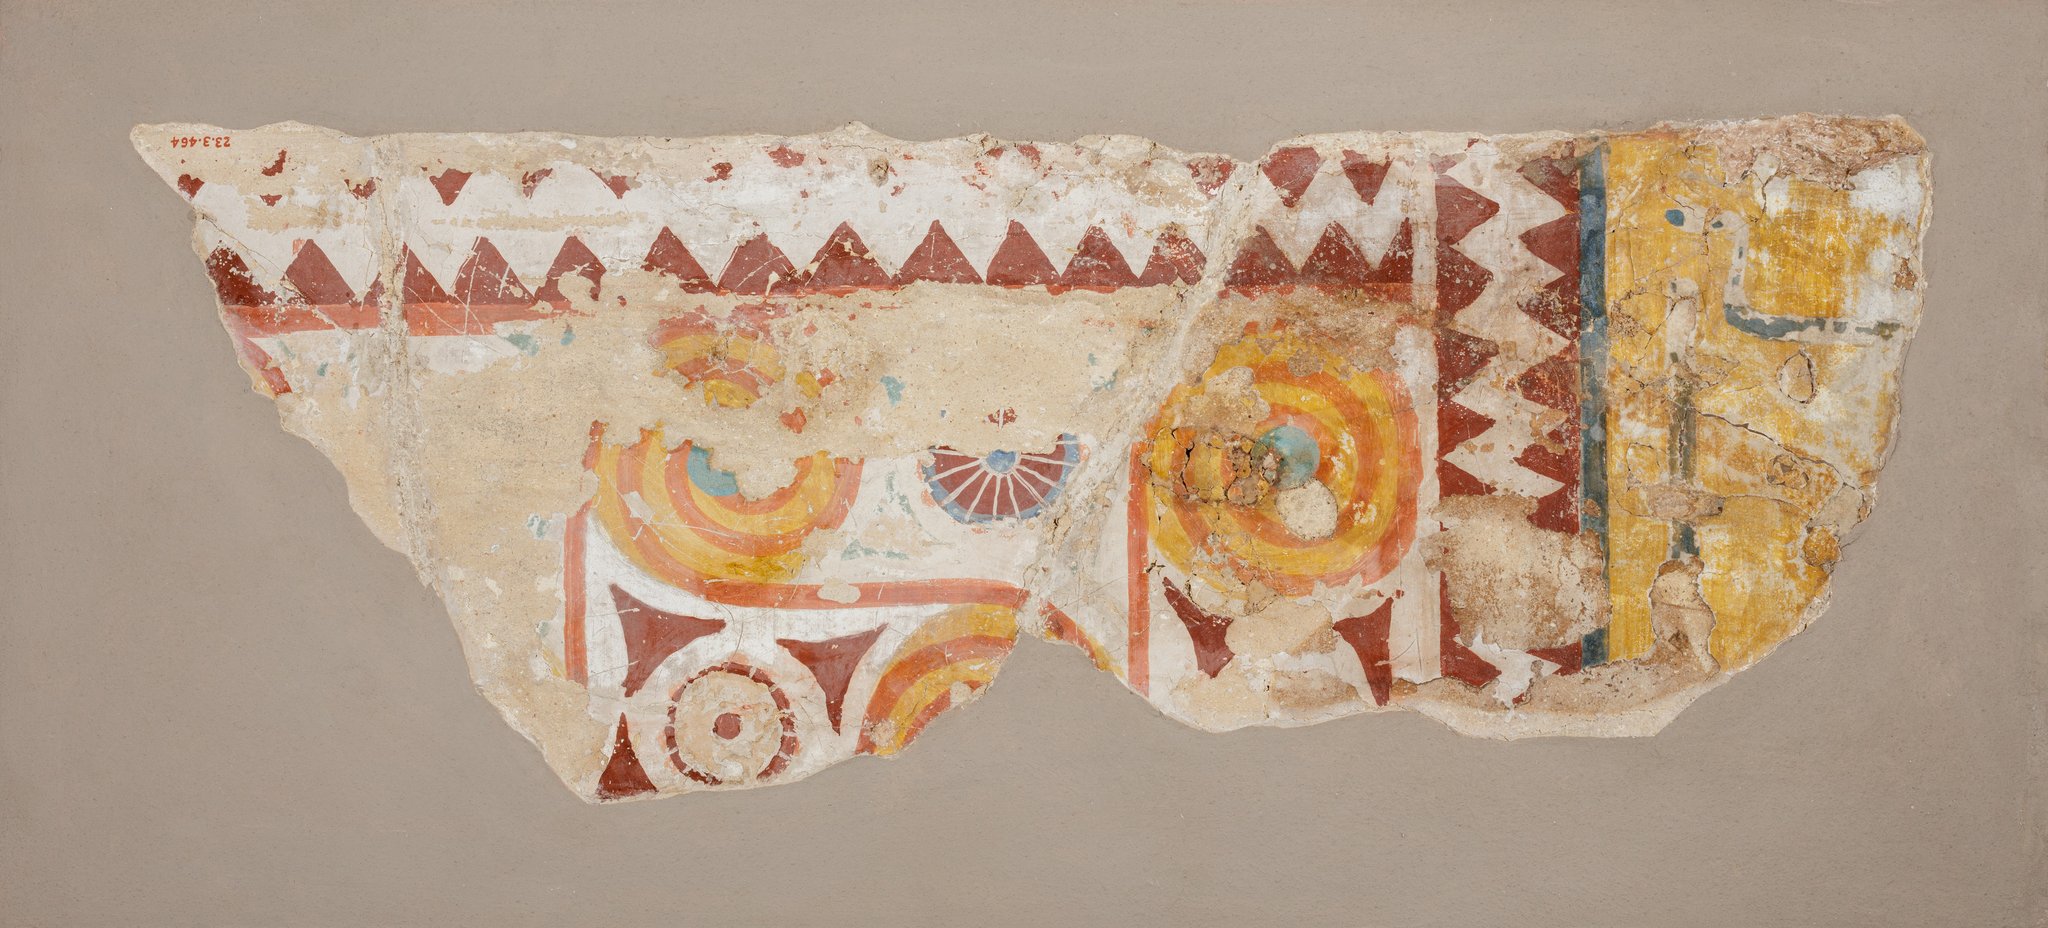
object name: ceiling painting, senenmut, tt 71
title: Ceiling Painting from the Tomb Chapel of Senenmut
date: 1479-1458 BCE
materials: mud, paint, plaster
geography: egypt